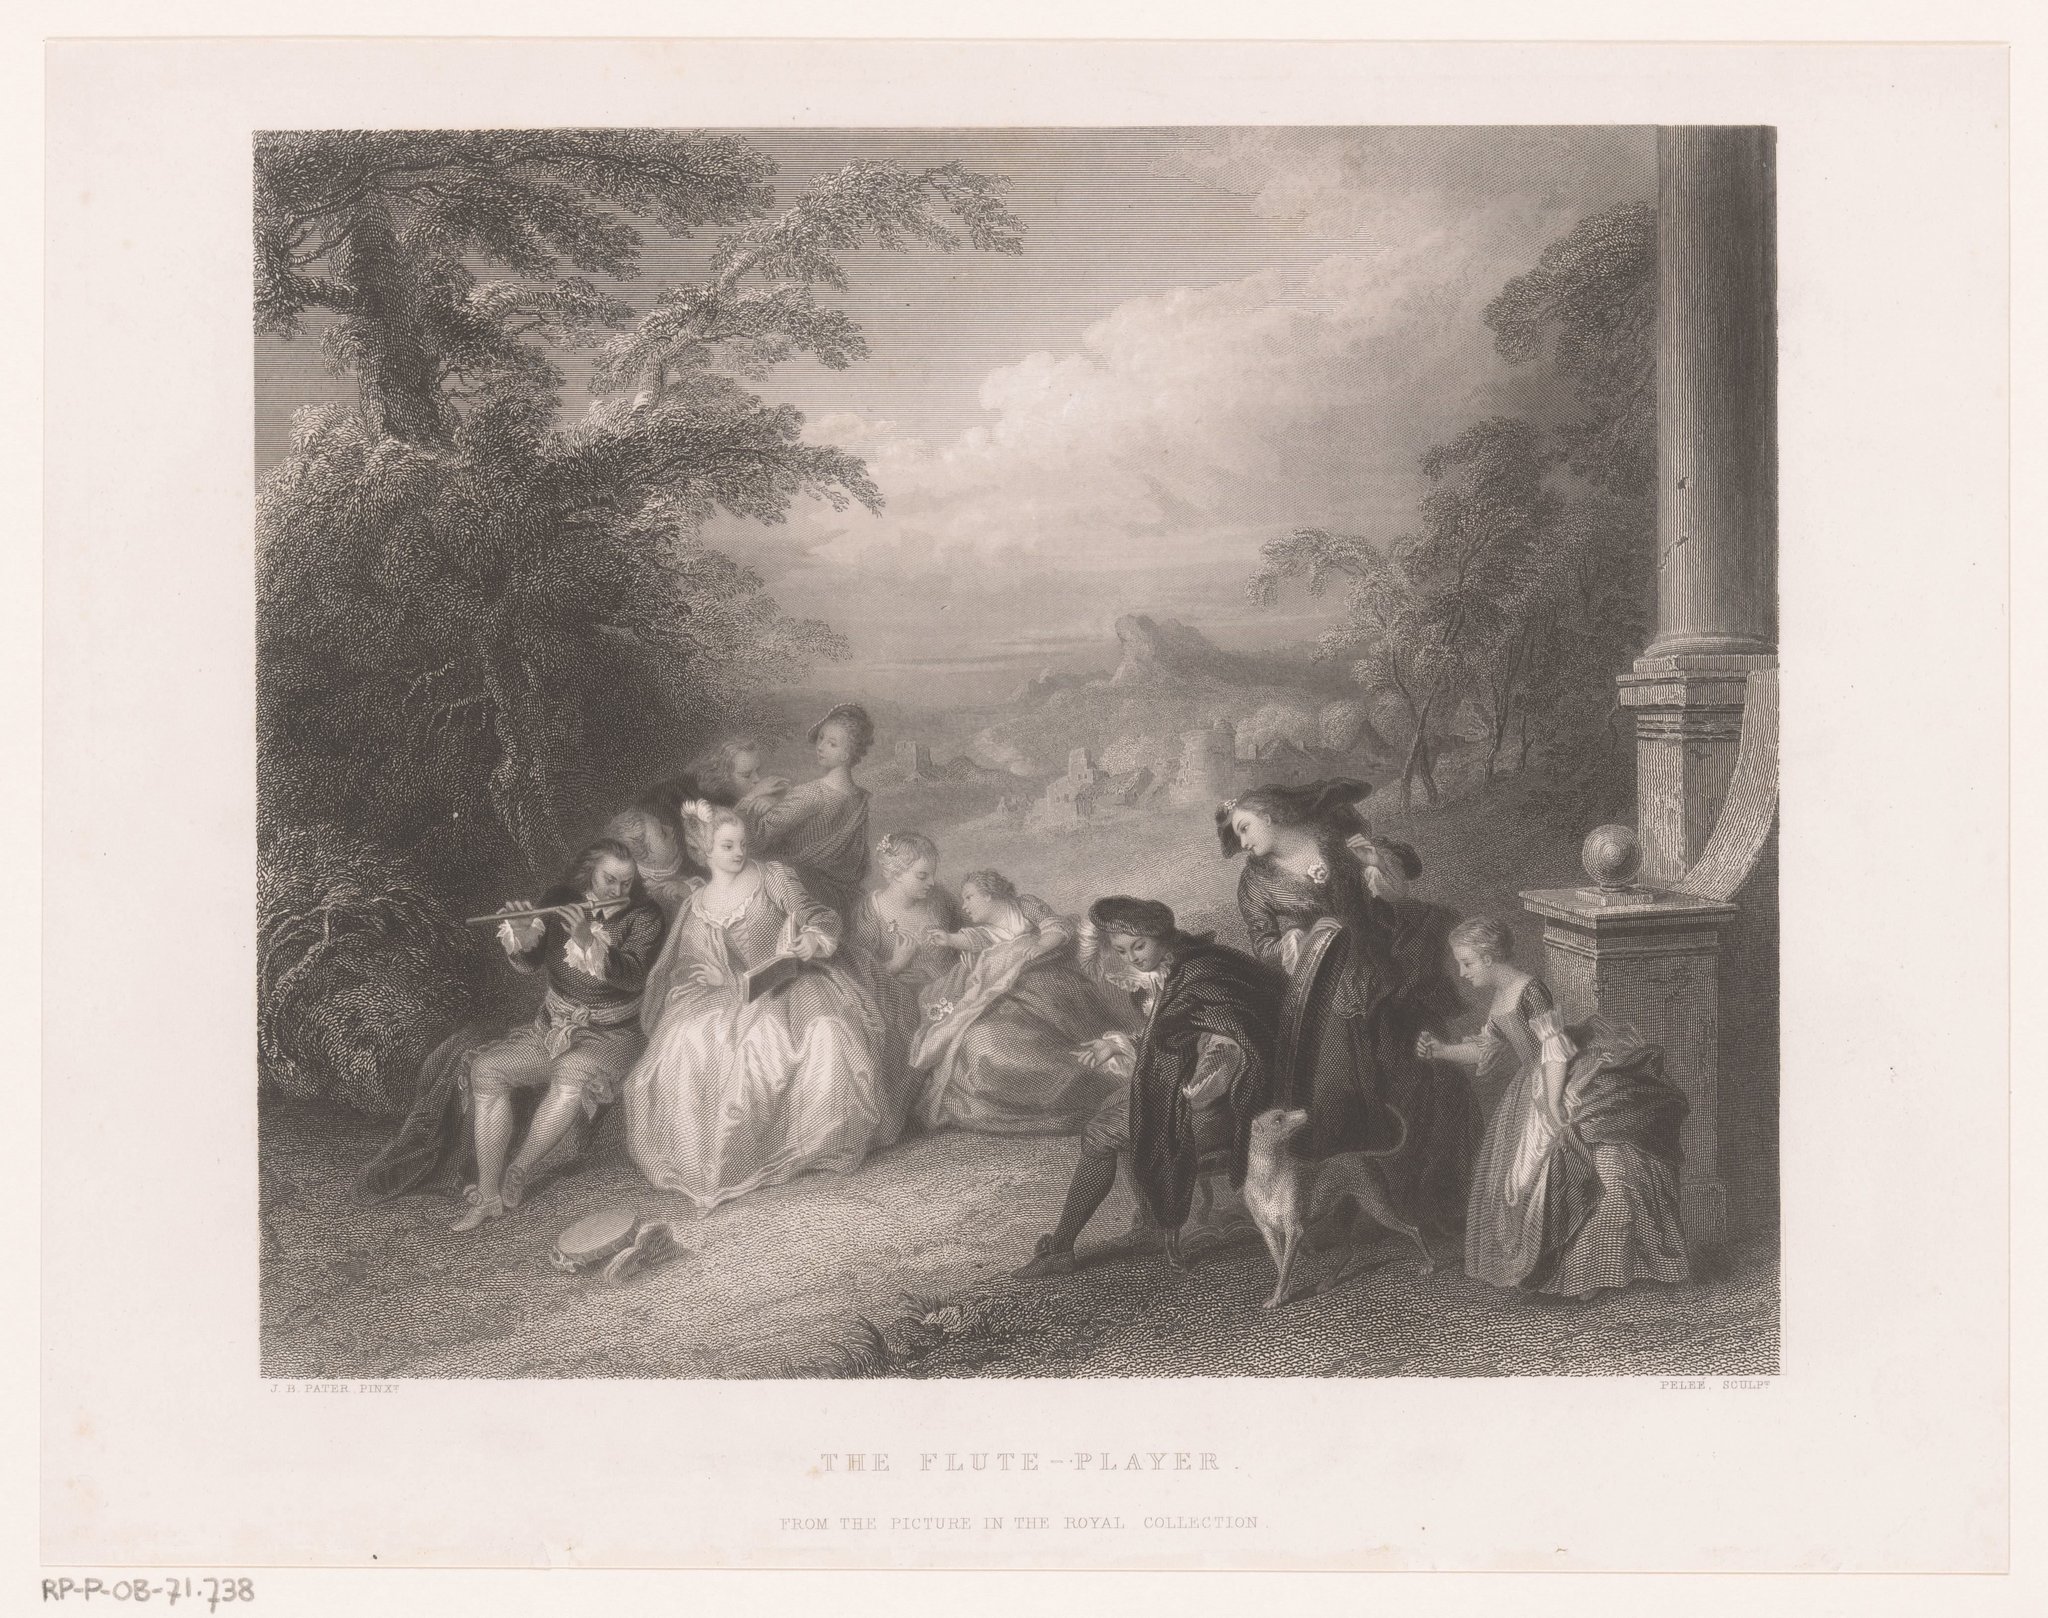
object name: print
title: Gezelschap in park met fluitspeler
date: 1811-1871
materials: paper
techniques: engraving, etching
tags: one person playing wind instrument, private festivities, merry company - aa - in the open air, 'fête champêtre'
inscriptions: collector's mark: Lugt 2228